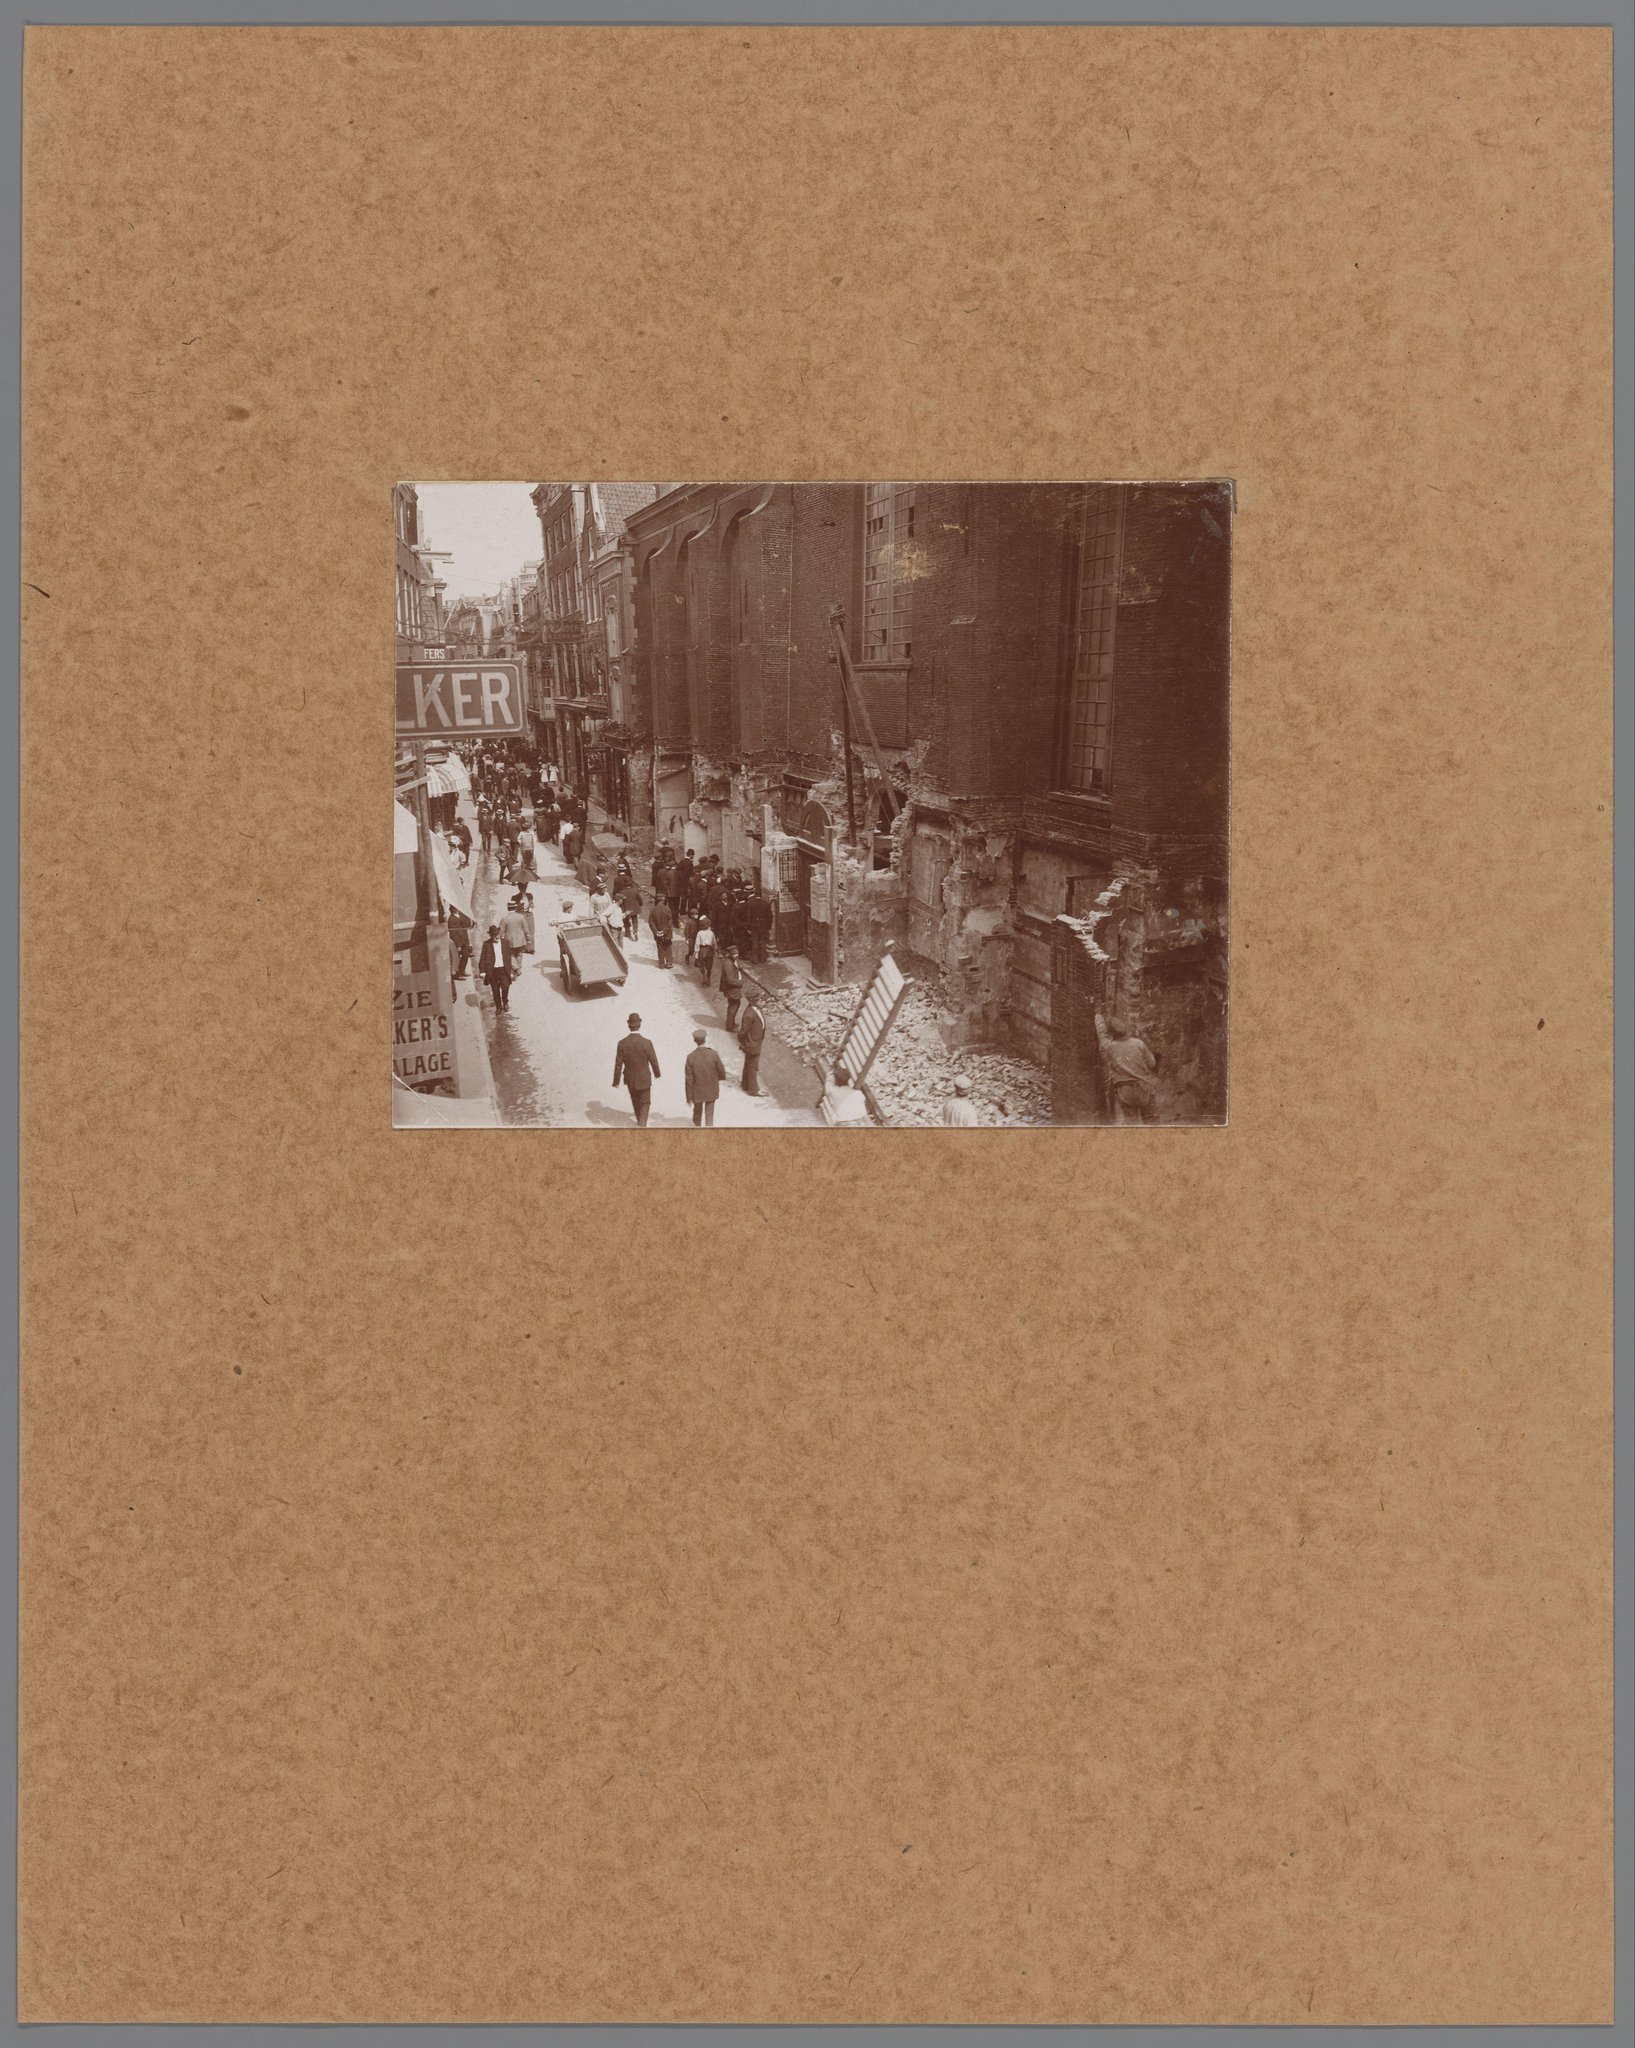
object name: photograph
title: Straatgezicht met de Nieuwezijds Kapel te Amsterdam tijdens de sloop in 1908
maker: Anonymous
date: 1908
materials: cardboard, photographic support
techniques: collodion silver print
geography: amsterdam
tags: church (exterior) - qq - small church, chapel, street (+ city(-scape) with figures, staffage)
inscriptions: annotation: ‘'08.150/ 446’, annotation: ‘N.Z. Kapel’, collector's mark: Lugt 2228